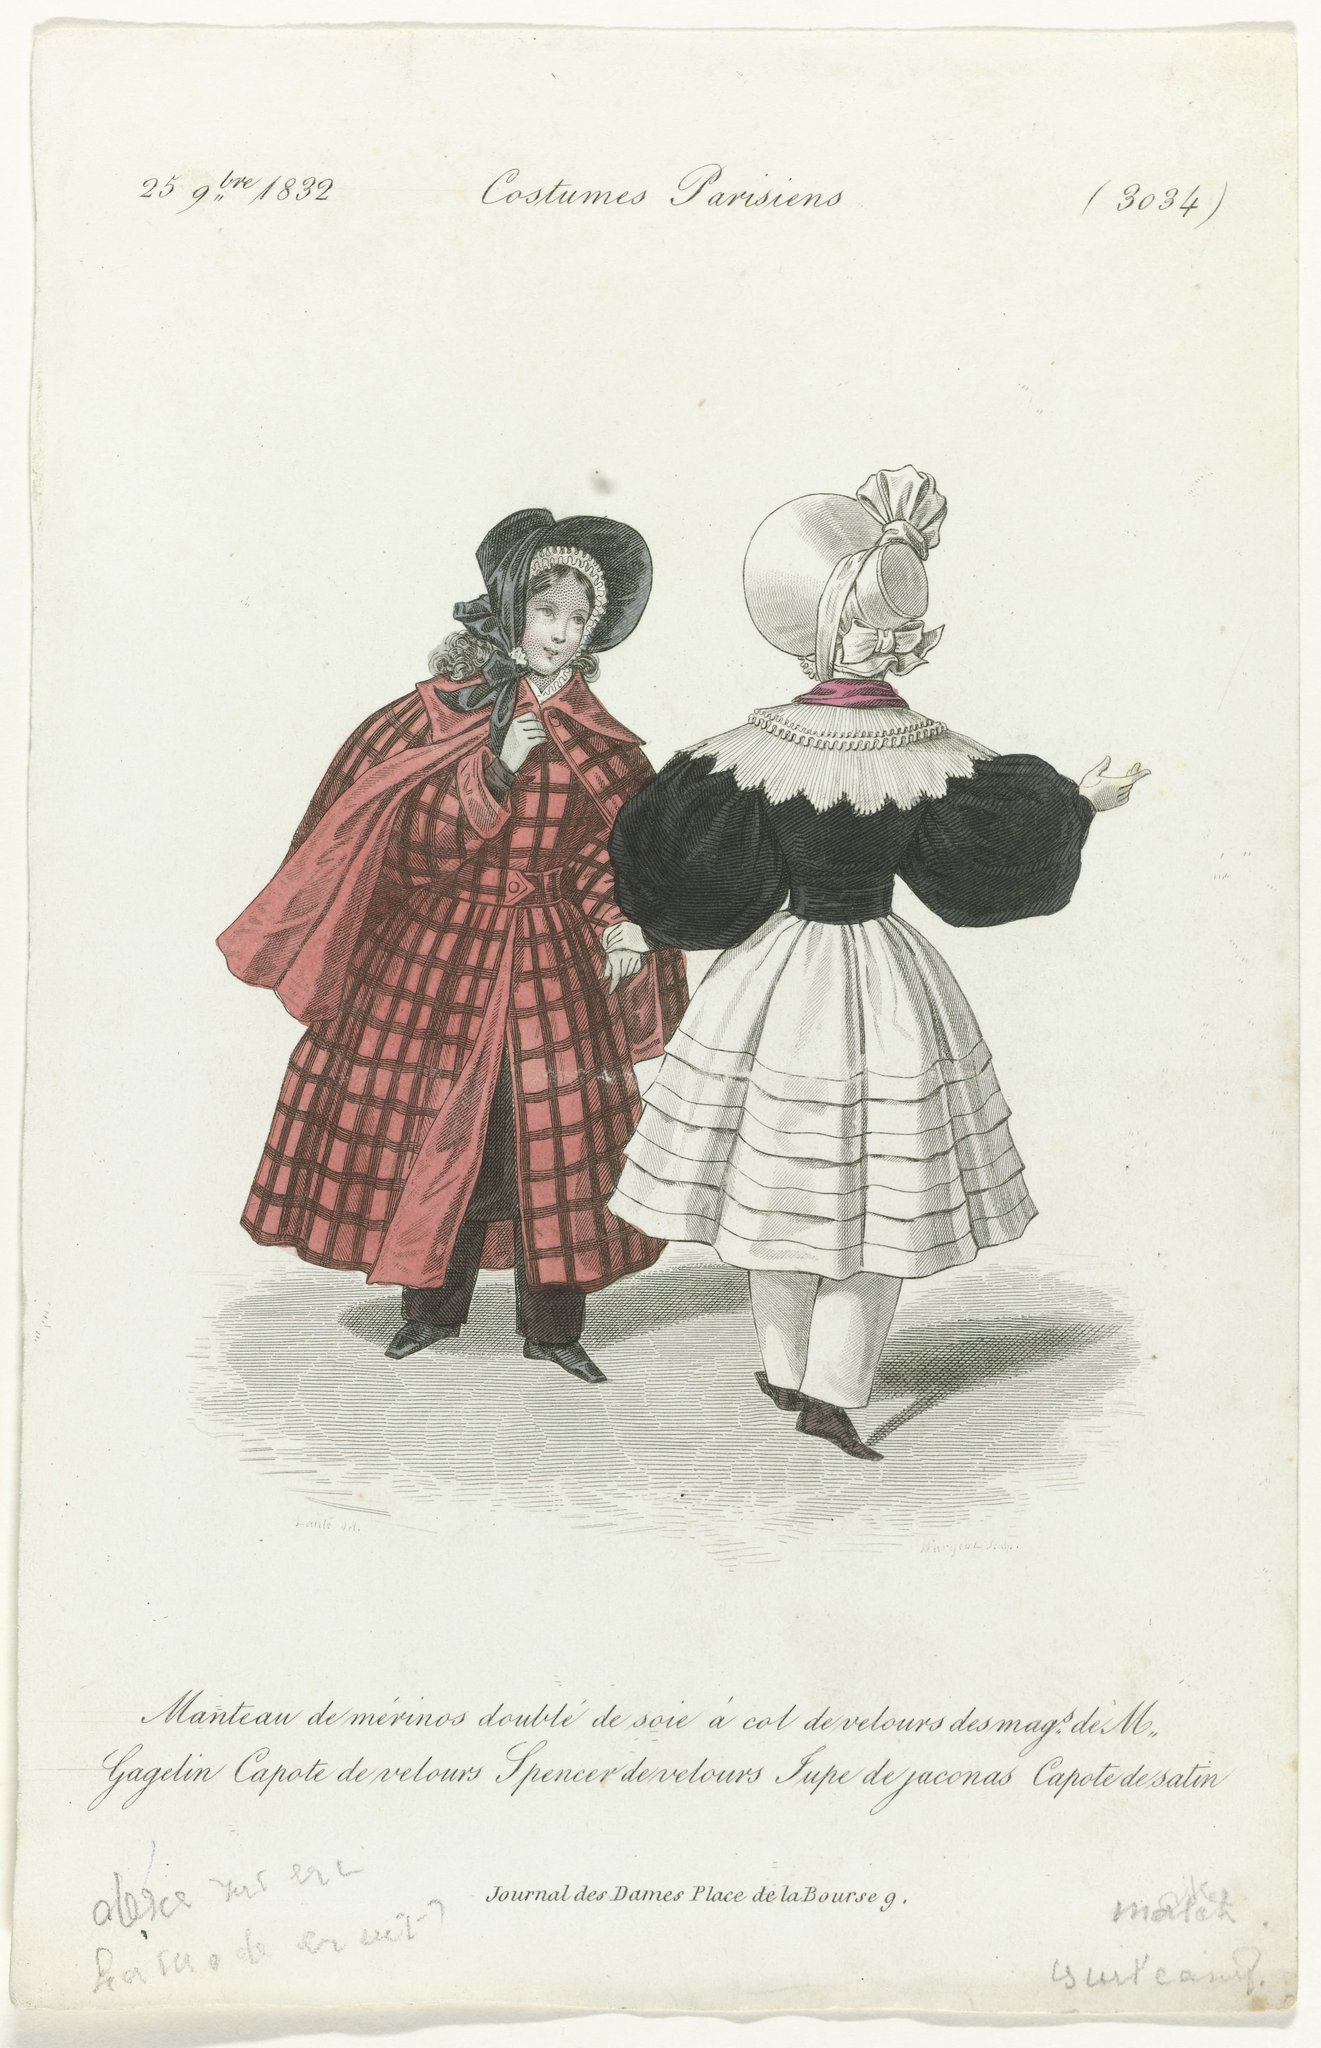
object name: fashion print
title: Journal des Dames et des Modes, Costumes Parisiens, 25 septembre 1832, (3034) : Manteau de mérinos (...)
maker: Anonymous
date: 1832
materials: paper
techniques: engraving, hand coloring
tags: underclothes for the lower part of the body: bloomers (+ girls' clothes), head-gear (capote) (+ girls' clothes), neck-gear: collar (+ girls' clothes), coat (+ girls' clothes), clothing for the upper part of the body (spencer) (+ girls' clothes), fashion plates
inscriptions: title: ‘Costumes Parisiens’, address: ‘Journal des Dames Place de la Bourse 9.’, caption: ‘Manteau de mérinos doublé de soie á col de velours des mag.s de M.Gagelin Capote de velours Spencer de velours Jupe de jaconas Capote de satin’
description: Meisje in een mantel van geruite merinowol gevoerd met zijde en een kraag van fluweel, uit de winkels van Gagelin. Capote van fluweel. Meisje, op de rug gezien, in een spencer van fluweel. Rok van 'jaconas' waaronder bloomers. Op het hoofd een capote van satijn. Prent uit het modetijdschrift Journal des Dames et des Modes (1797-1839).